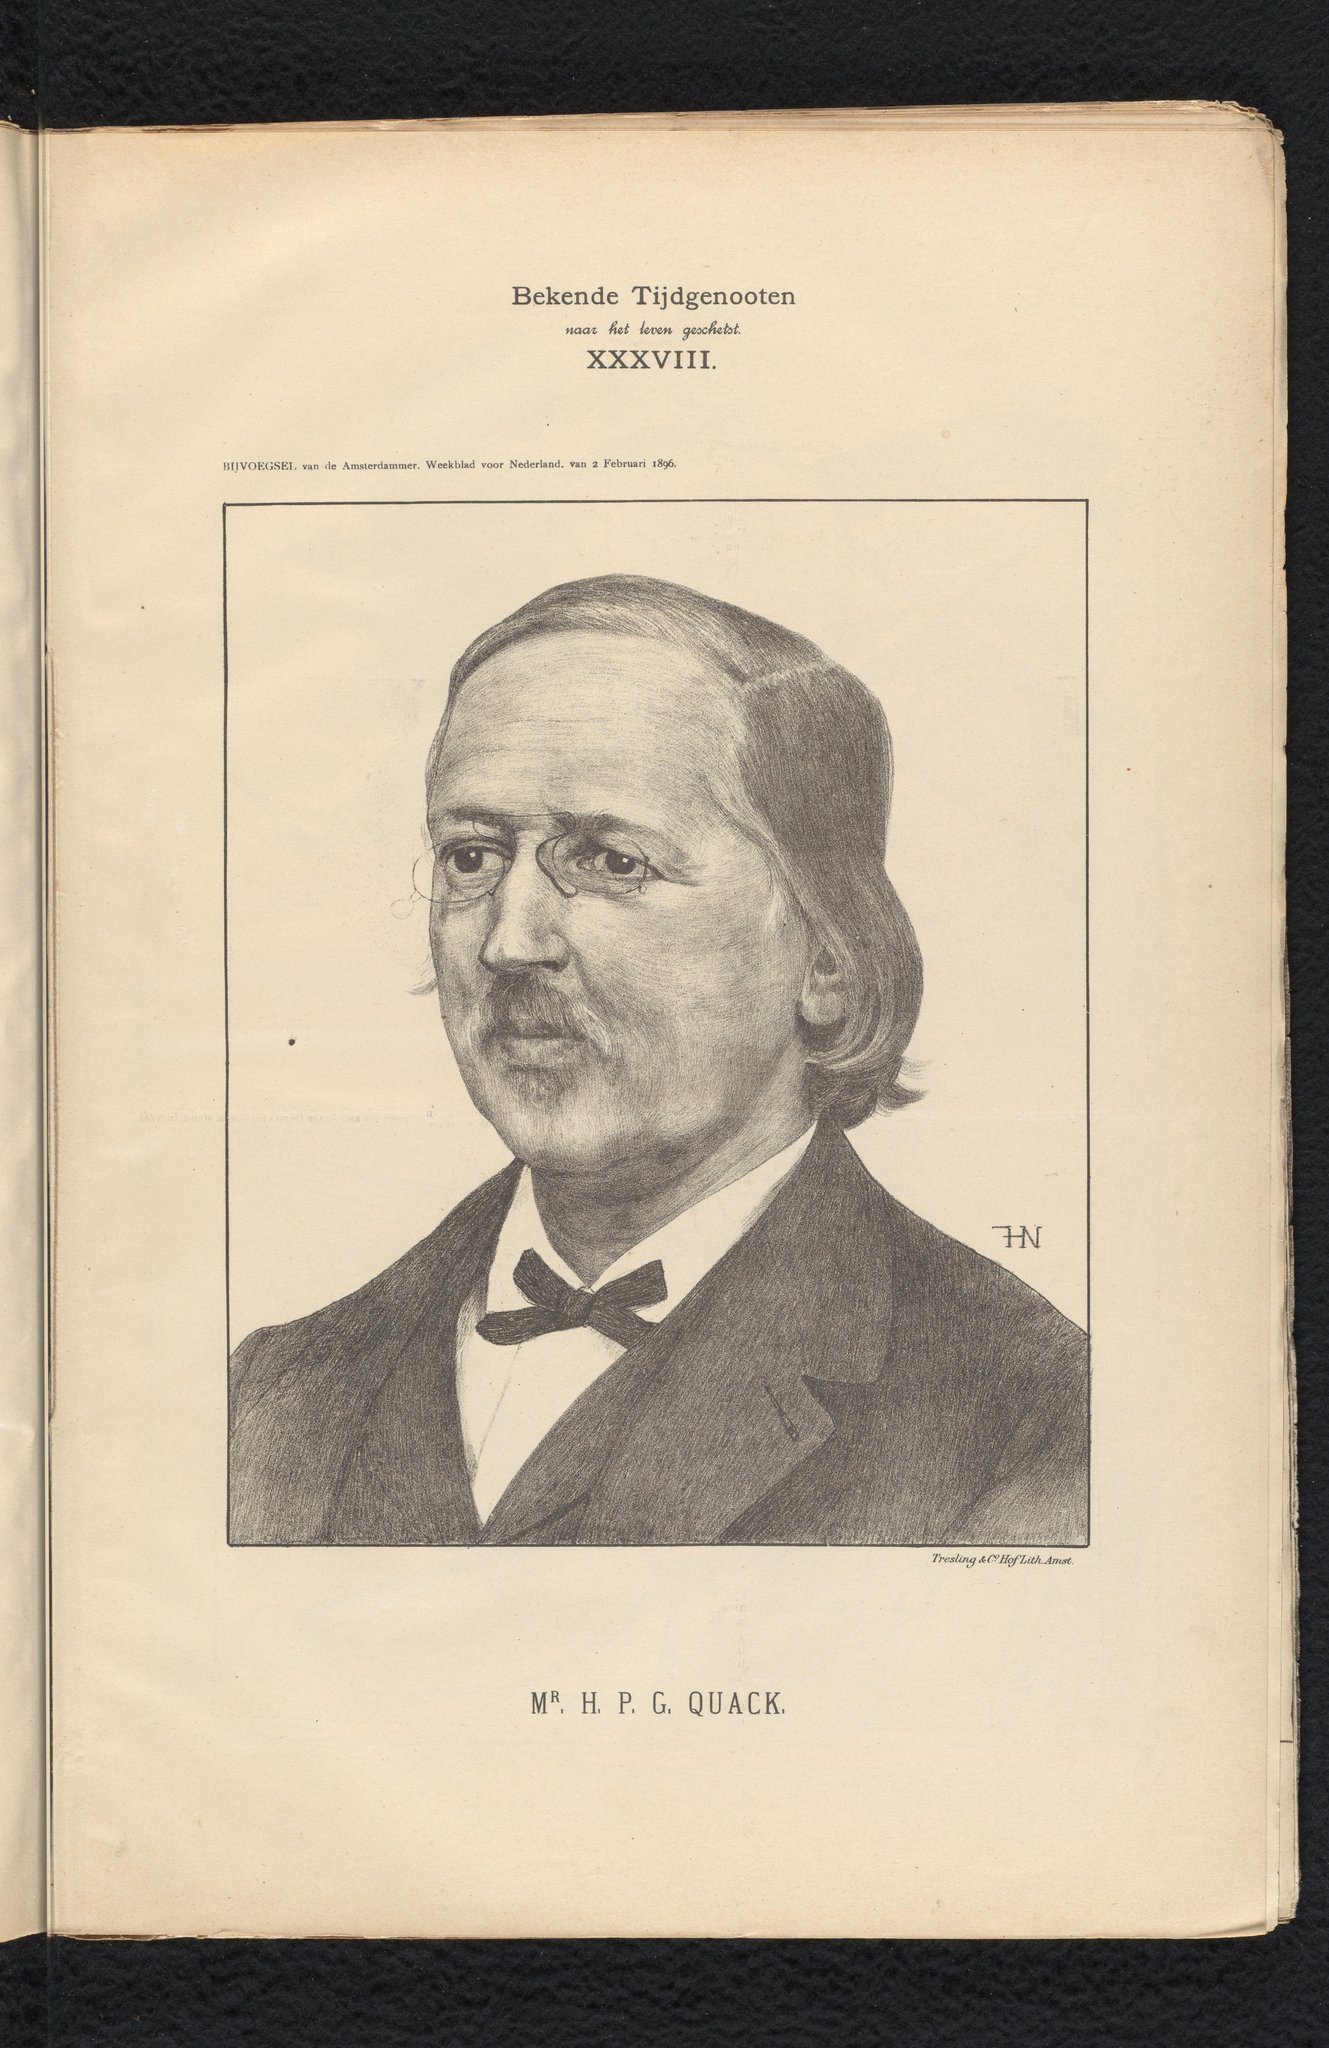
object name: print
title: Mr. H.P.G. Quack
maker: ferdinand hart nibbrig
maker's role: draughtsman, painter, print maker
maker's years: 1866-1915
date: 1896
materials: paper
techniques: lithograph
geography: amsterdam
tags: amsterdam, hendrick peter godfried quack, historical persons, professor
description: Portret van Hendrick Peter Godfried Quack, hoogleraar in de rechtsgeleerdheid aan de Utrechtse hogeschool, jurist, econoom en geschiedschrijver. In de serie 'Bekende Tijdgenooten', nr. XXXVIII.